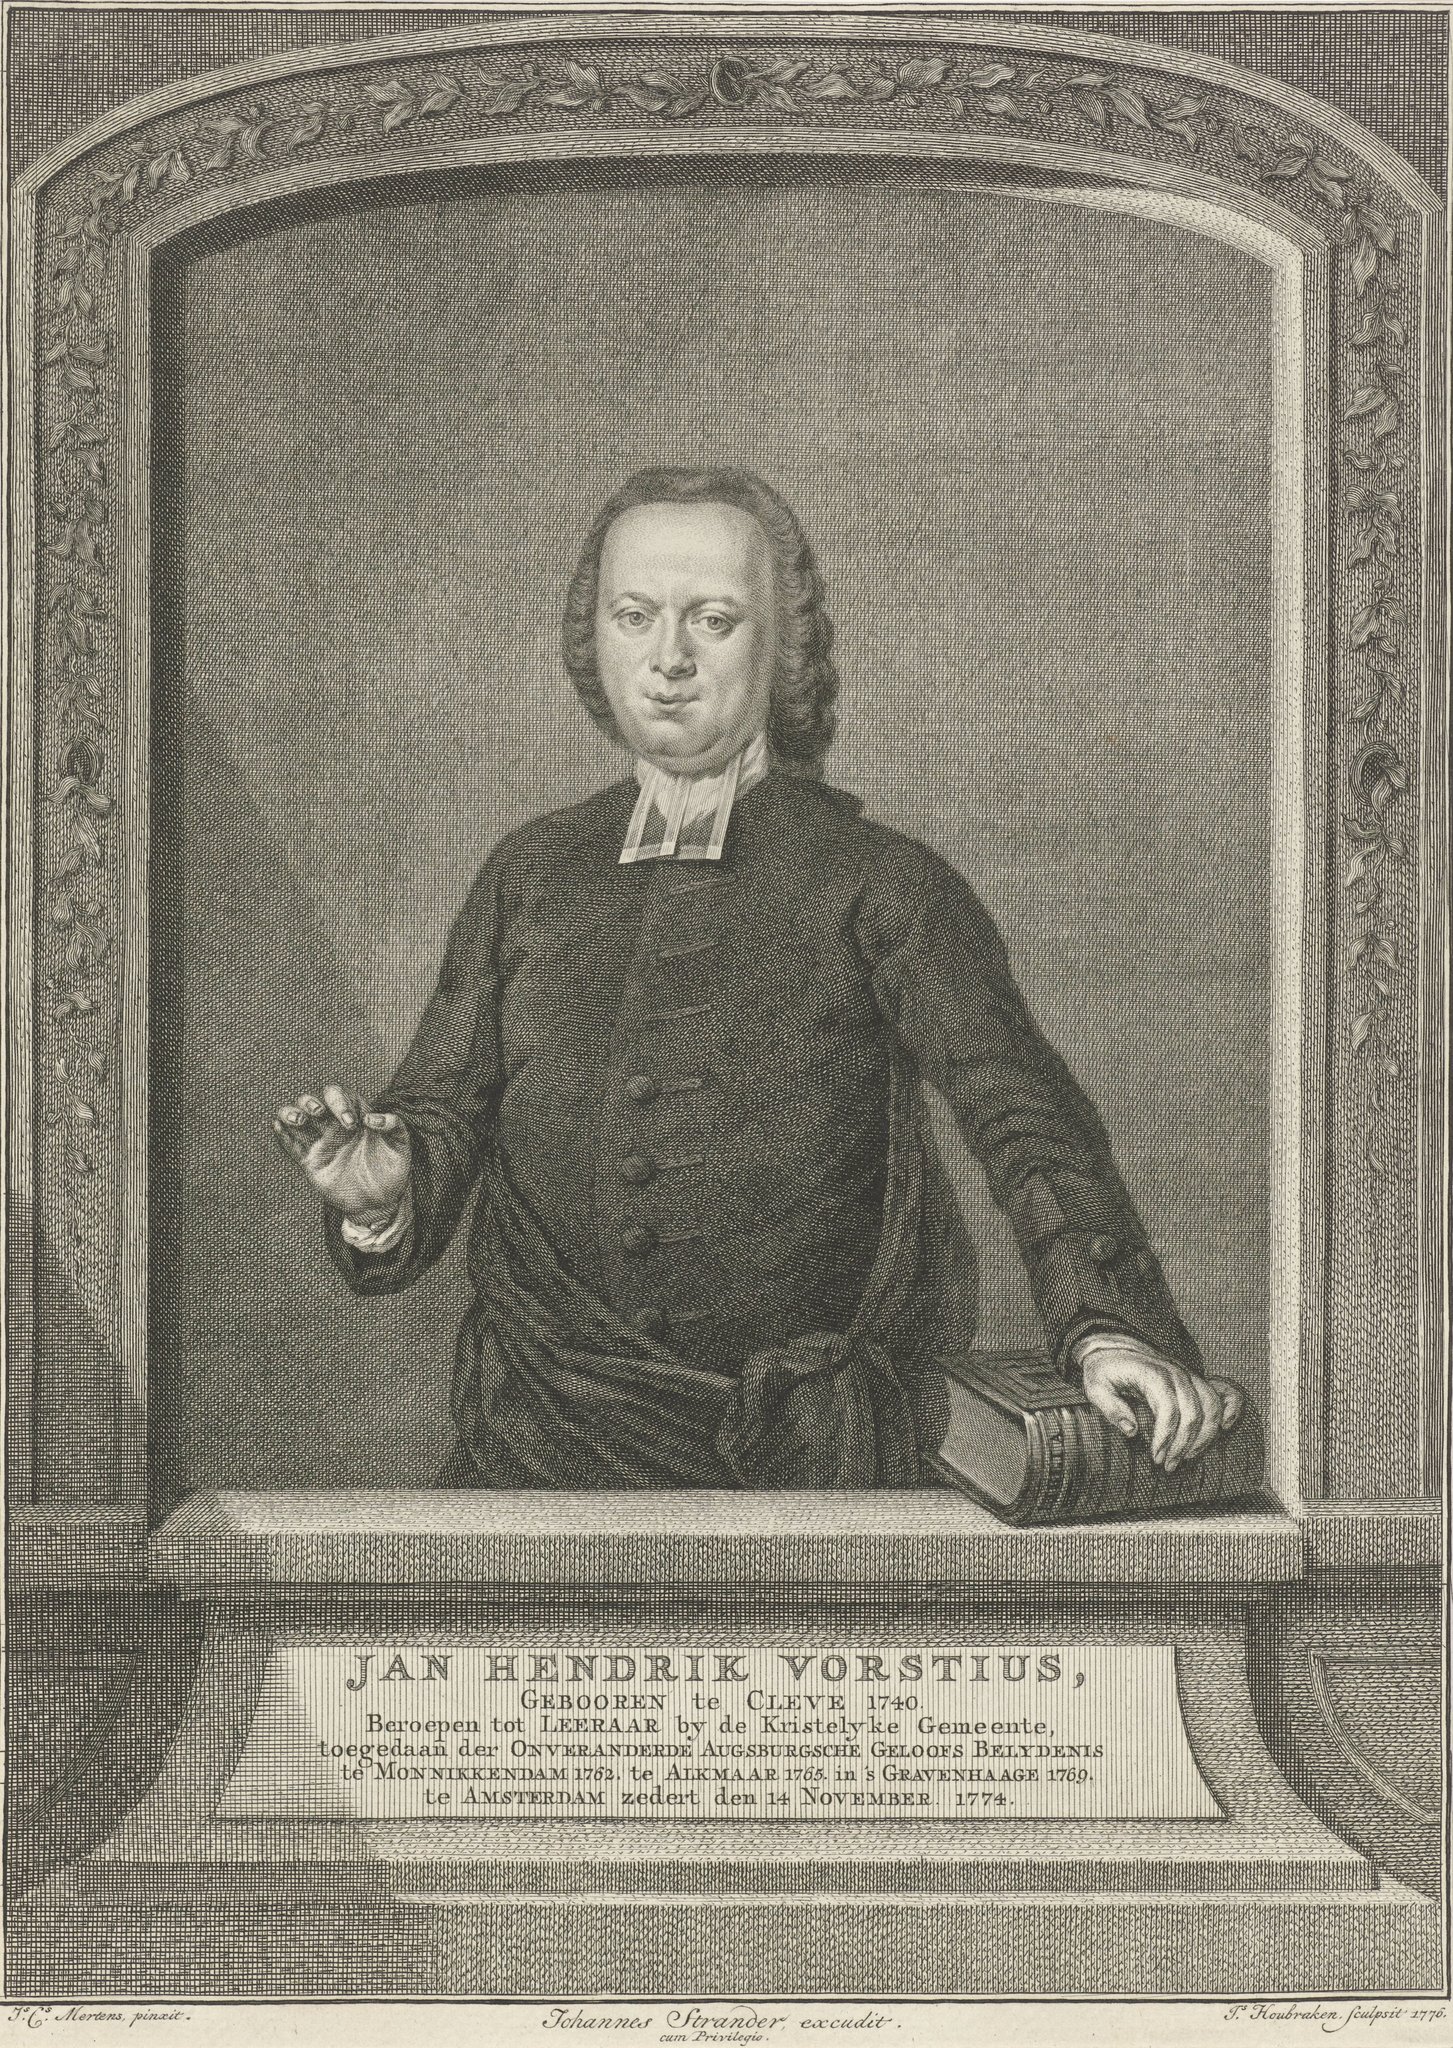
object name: print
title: Portret van Jan Hendrik Vorstius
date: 1776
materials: paper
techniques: engraving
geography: amsterdam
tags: cleves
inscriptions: collector's mark: Lugt 2228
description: Portret ten halven lijve van Jan Hendrik Vorstius in een architectonische omlijsting, zijn hand rustende op een bijbel. Onder de vensterbank zijn naam en gegevens in zes regels in het Nederlands.